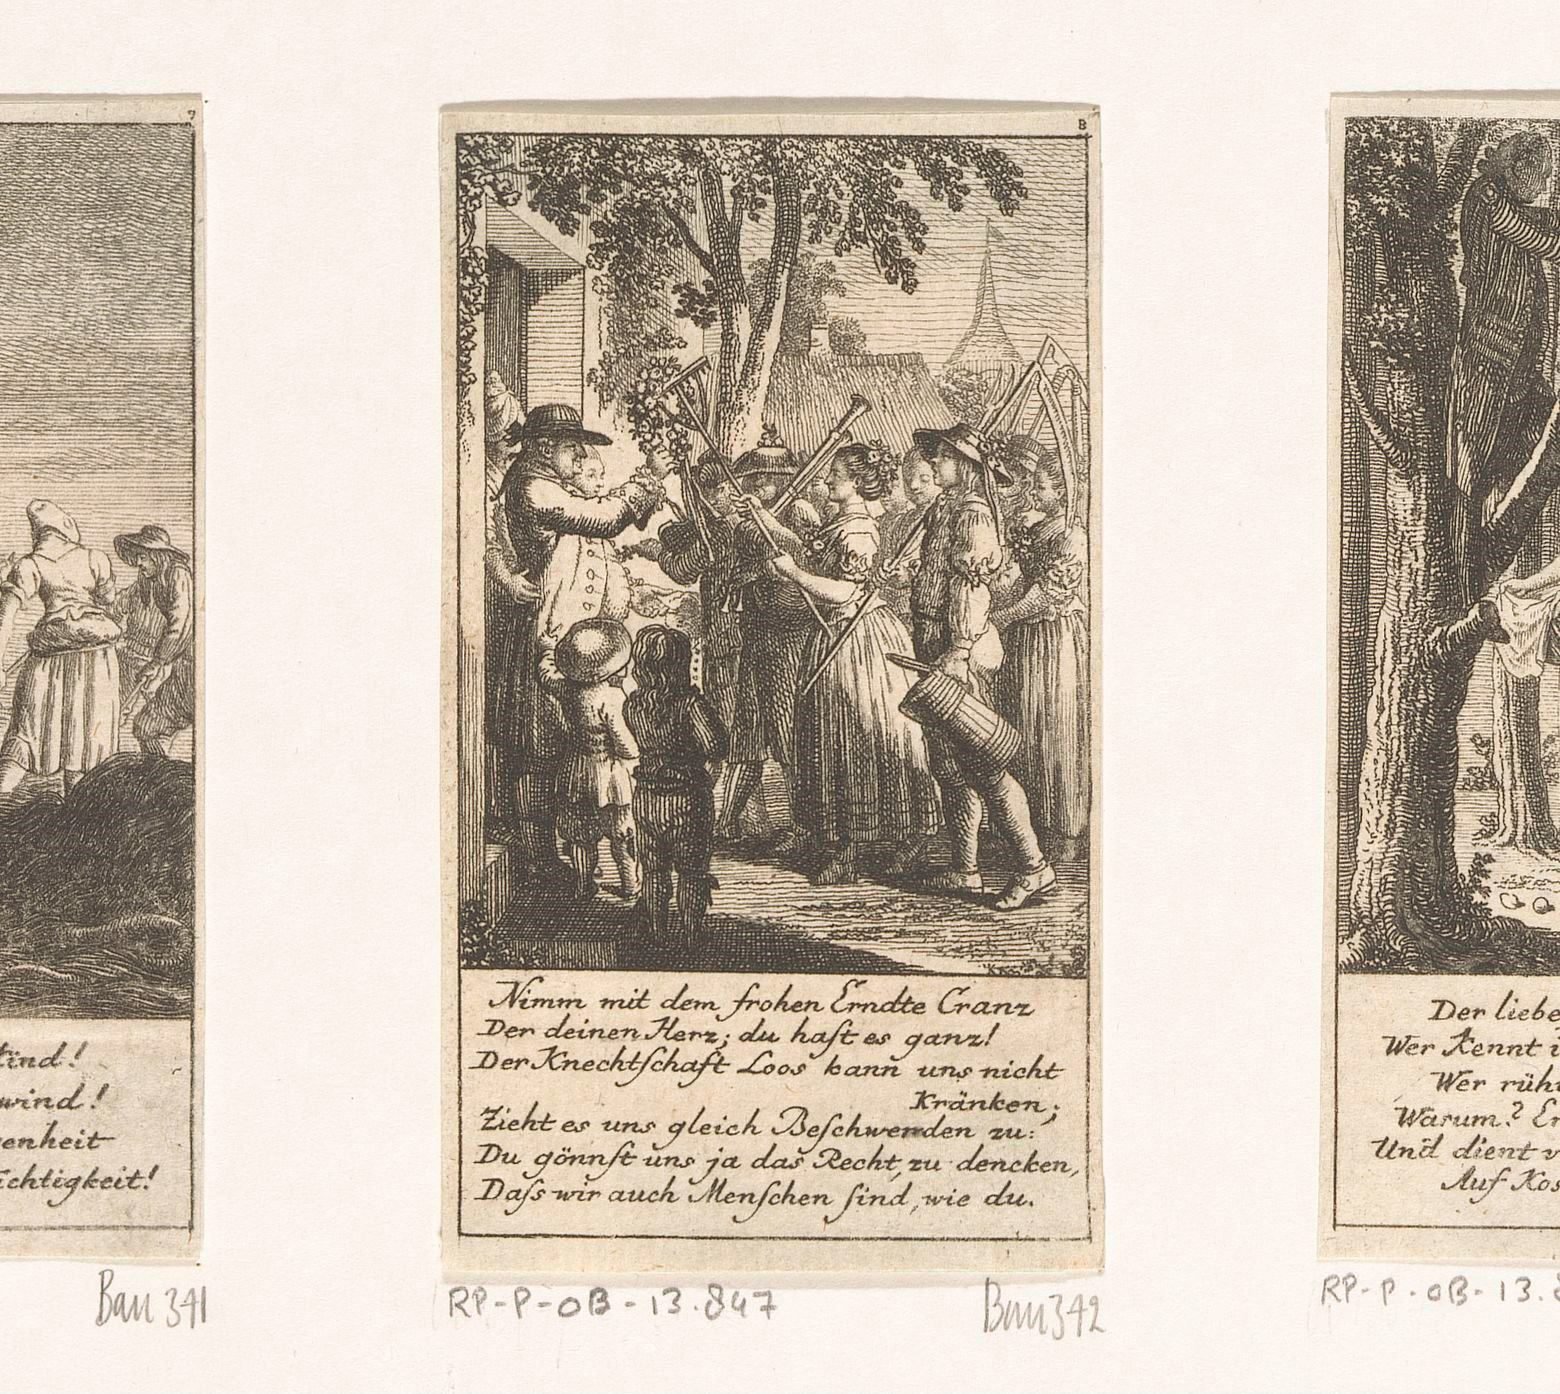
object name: print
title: Augustus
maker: daniel nikolaus chodowiecki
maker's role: draughtsman, print maker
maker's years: 1726-1801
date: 1777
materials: paper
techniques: etching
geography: berlin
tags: harvest festivities, august and its 'labours'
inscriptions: collector's mark: Lugt 2228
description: Afkomstig uit een serie met de twaalf maanden. Deze serie werd op een plaat geëtst. Deze serie is ook gebruikt in: Königl. Großbrit. Churf. Braunschw. Lüneb. Genealogischen Kalender, auf das Jahr 1778. Lauenburg: Johann Georg Berenberg.